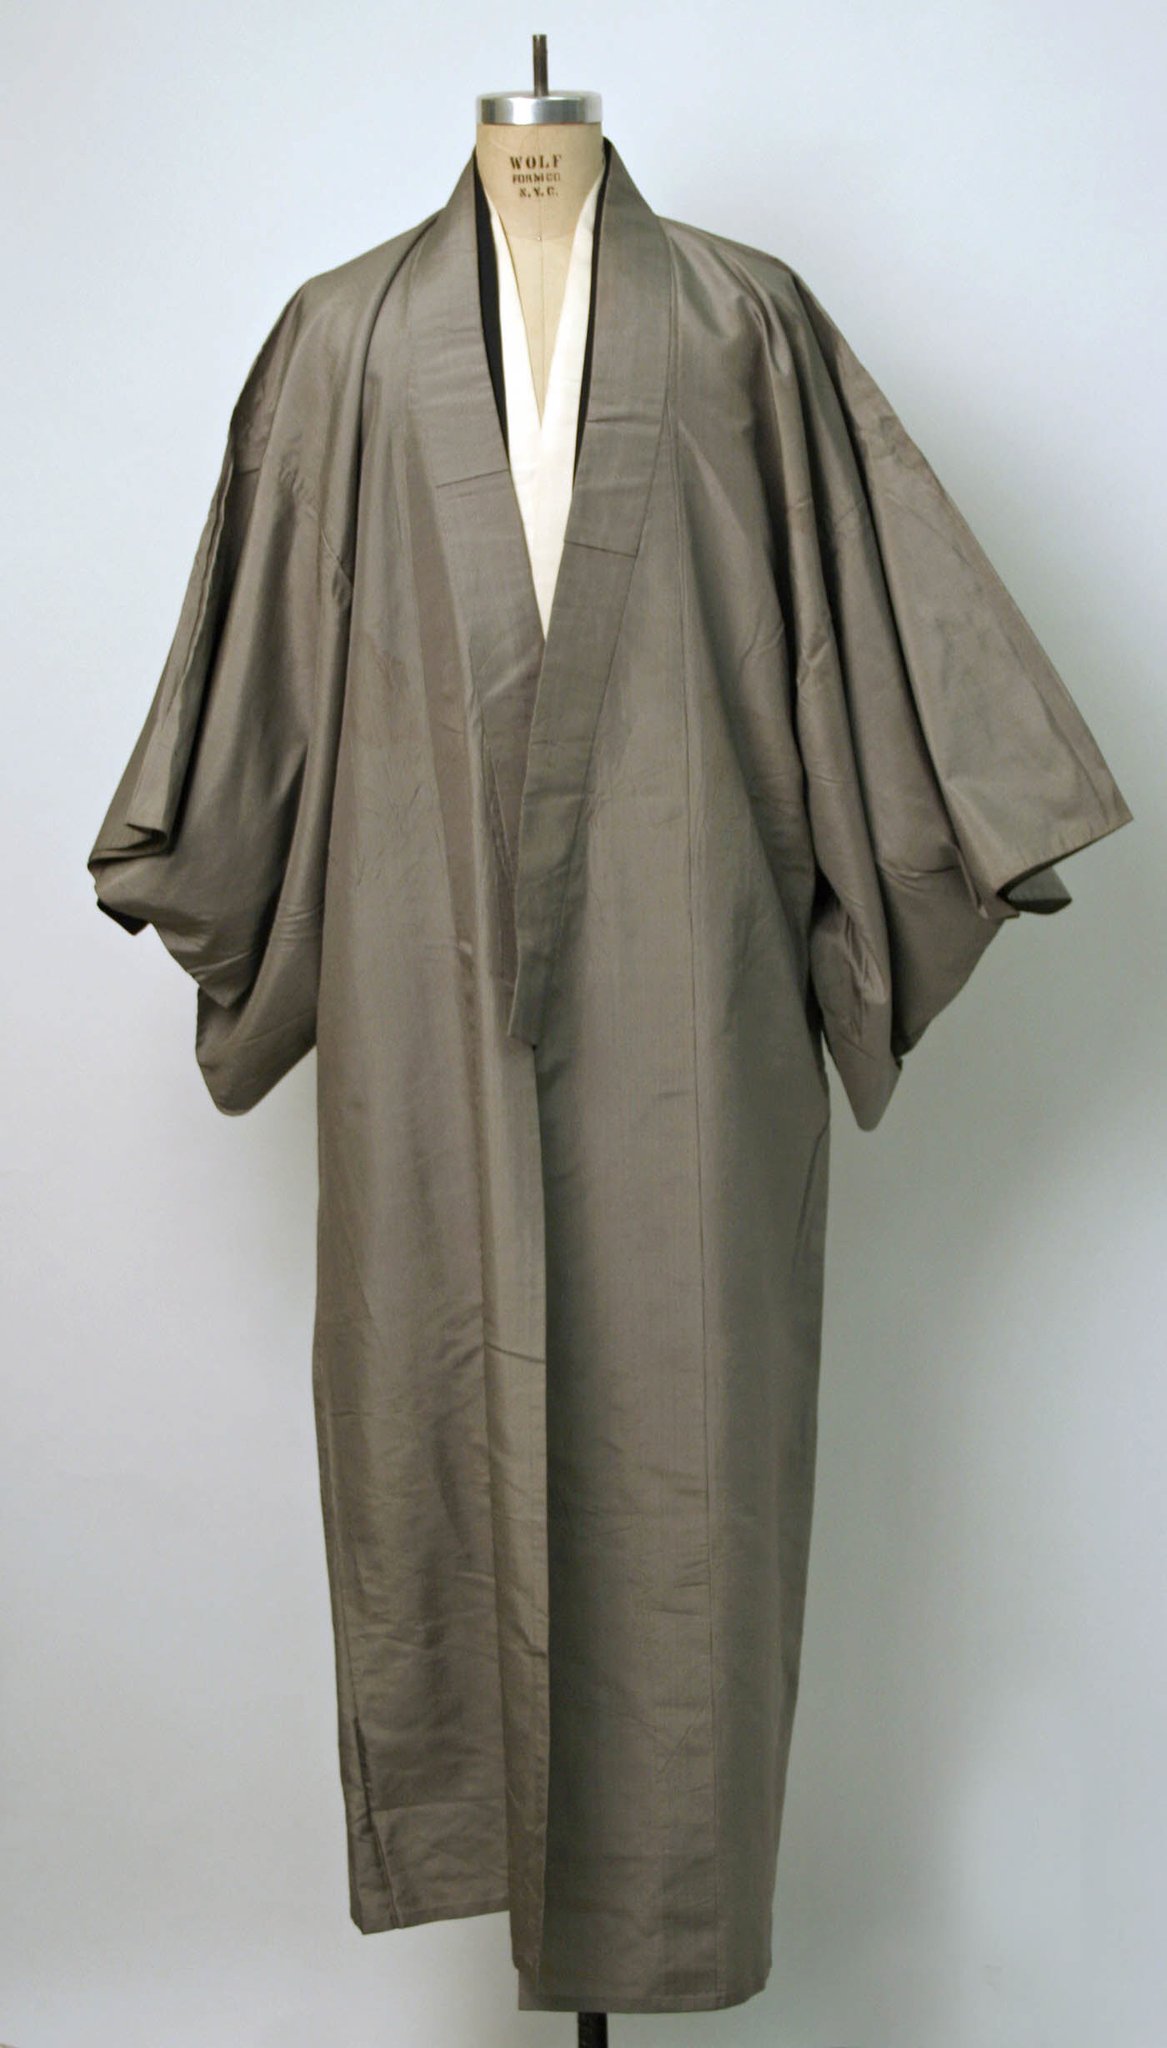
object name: ensemble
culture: japanese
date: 1901-1950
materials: silk